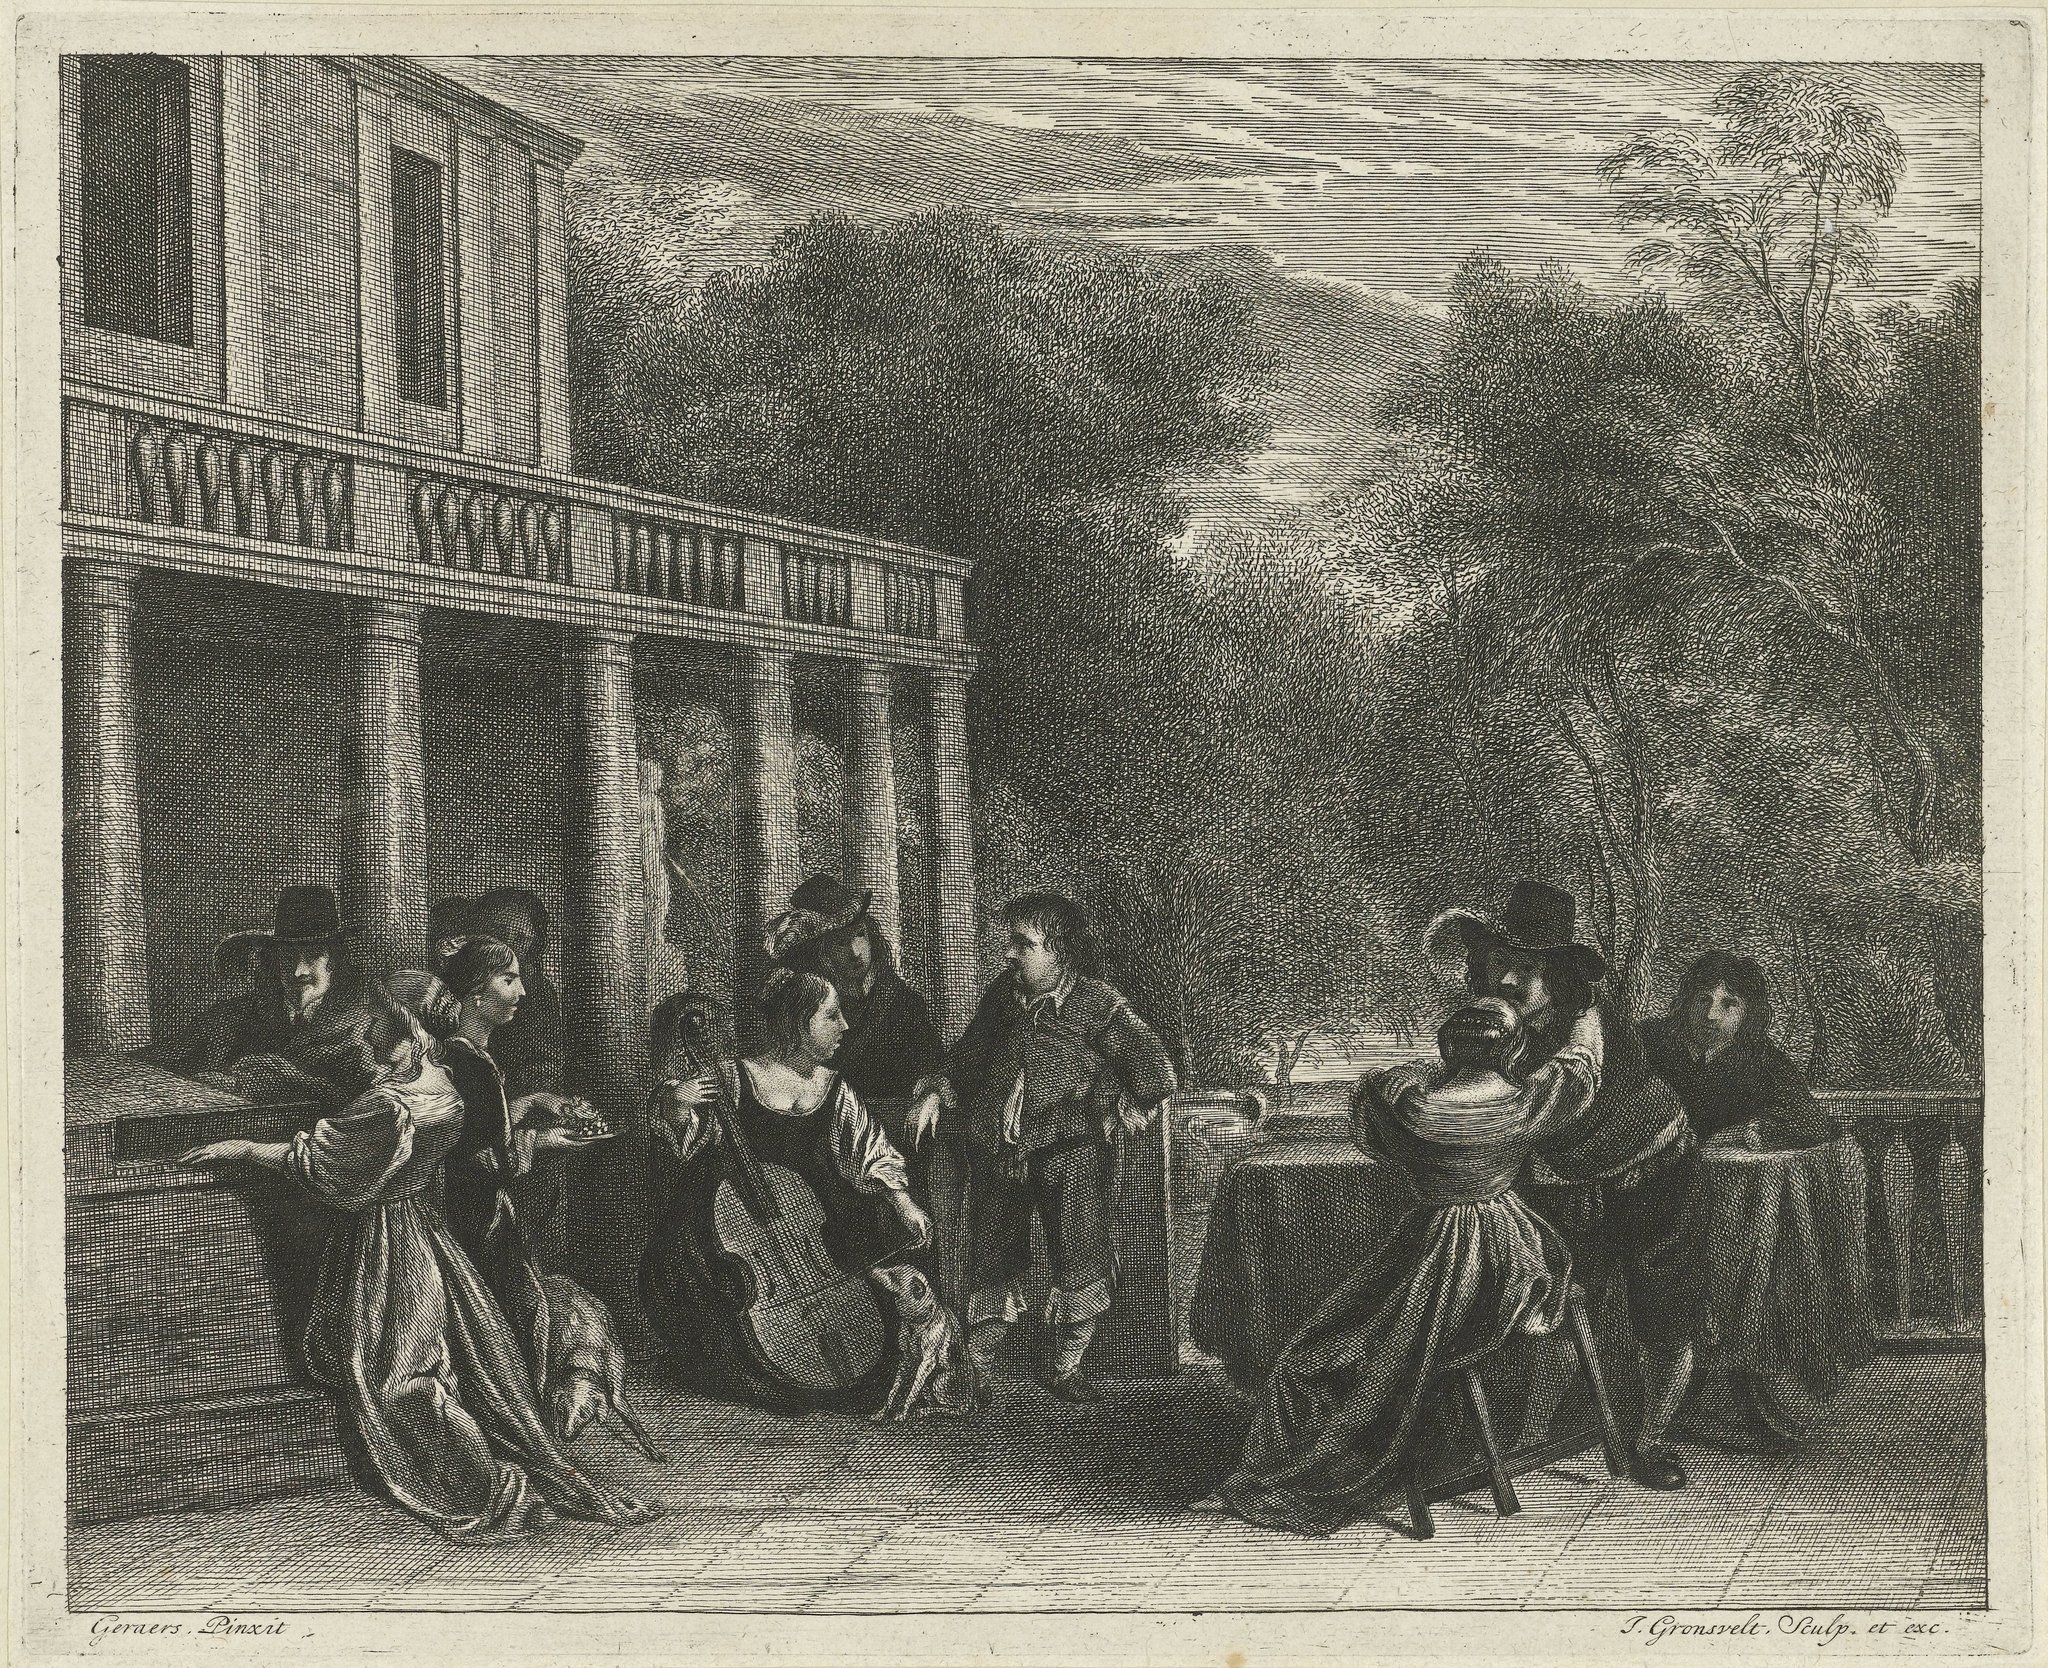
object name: print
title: Musicerend gezelschap op bordes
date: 1679-1728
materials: paper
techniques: engraving, etching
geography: amsterdam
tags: private festivities, merry company, small group of musicians, chamber orchestra, jazz band - cc - 'concert champêtre'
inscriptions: collector's mark: Lugt 240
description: Musicerend gezelschap op bordes: links een vrouw spelend op een toetsinstrument en naast haar een vrouw spelend op een viola da gamba. Rechts een man en vrouw bij een tafel, elkaar omhelzend.